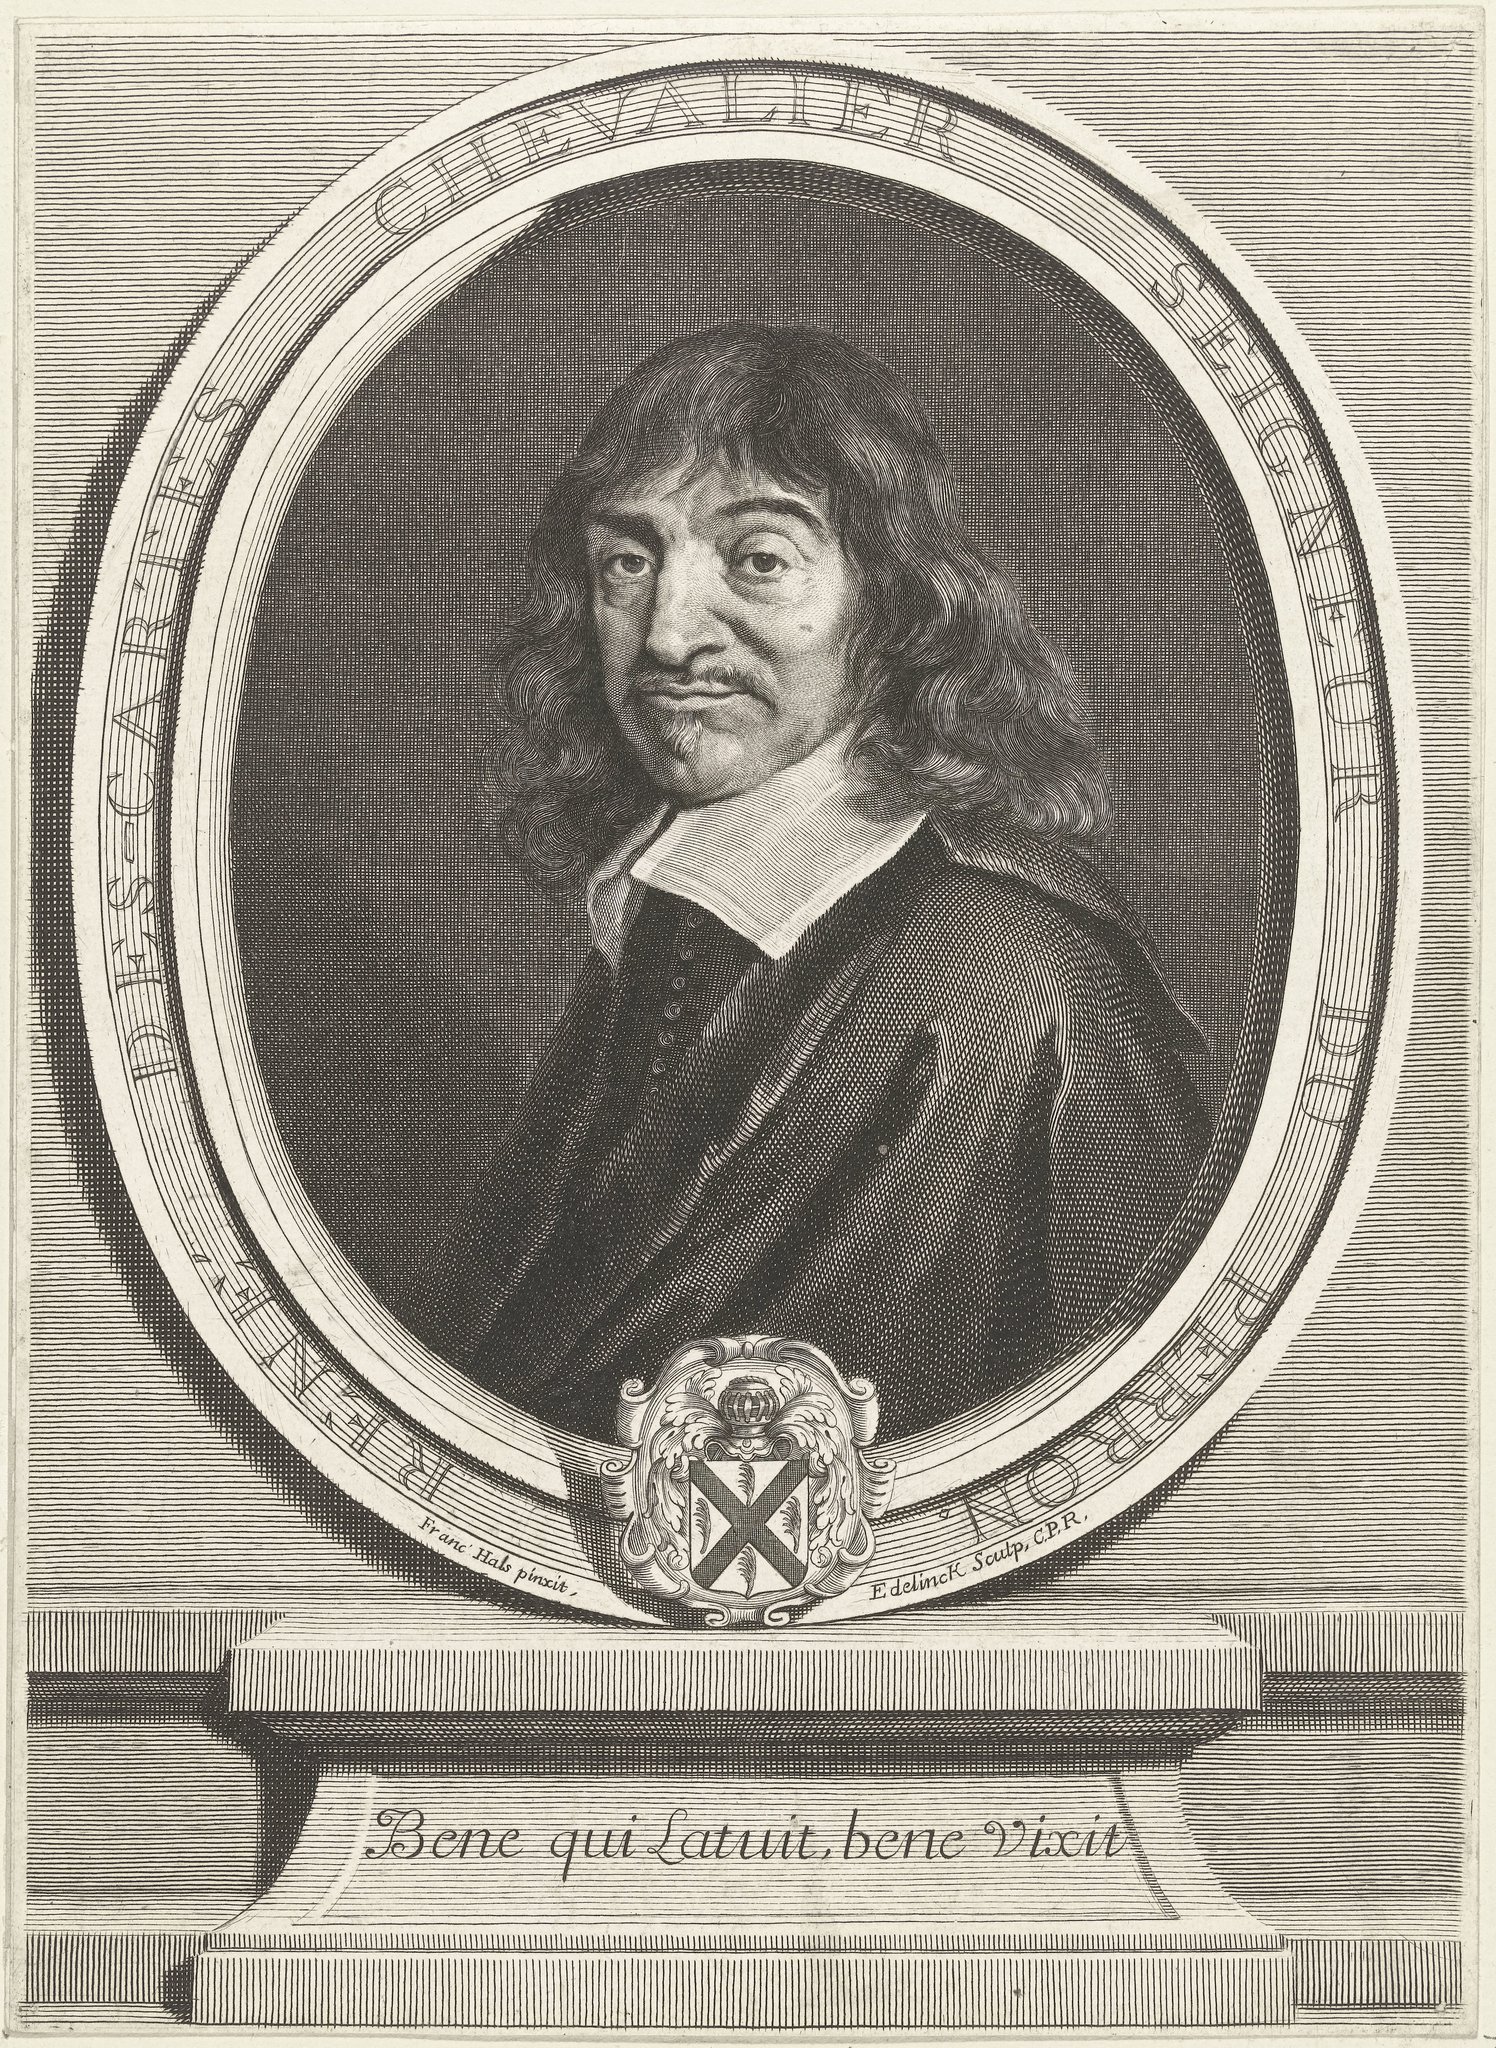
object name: print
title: Portret van René Descartes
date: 1666-1707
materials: paper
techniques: engraving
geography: paris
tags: rené descartes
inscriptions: collector's mark: Lugt 240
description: Portret van de filosoof René Descartes (1596-1650), afgebeeld in ovale omlijsting met tekst en wapen. Op een voetstuk met de tekst: Bene qui Latuit, bene Vixit.